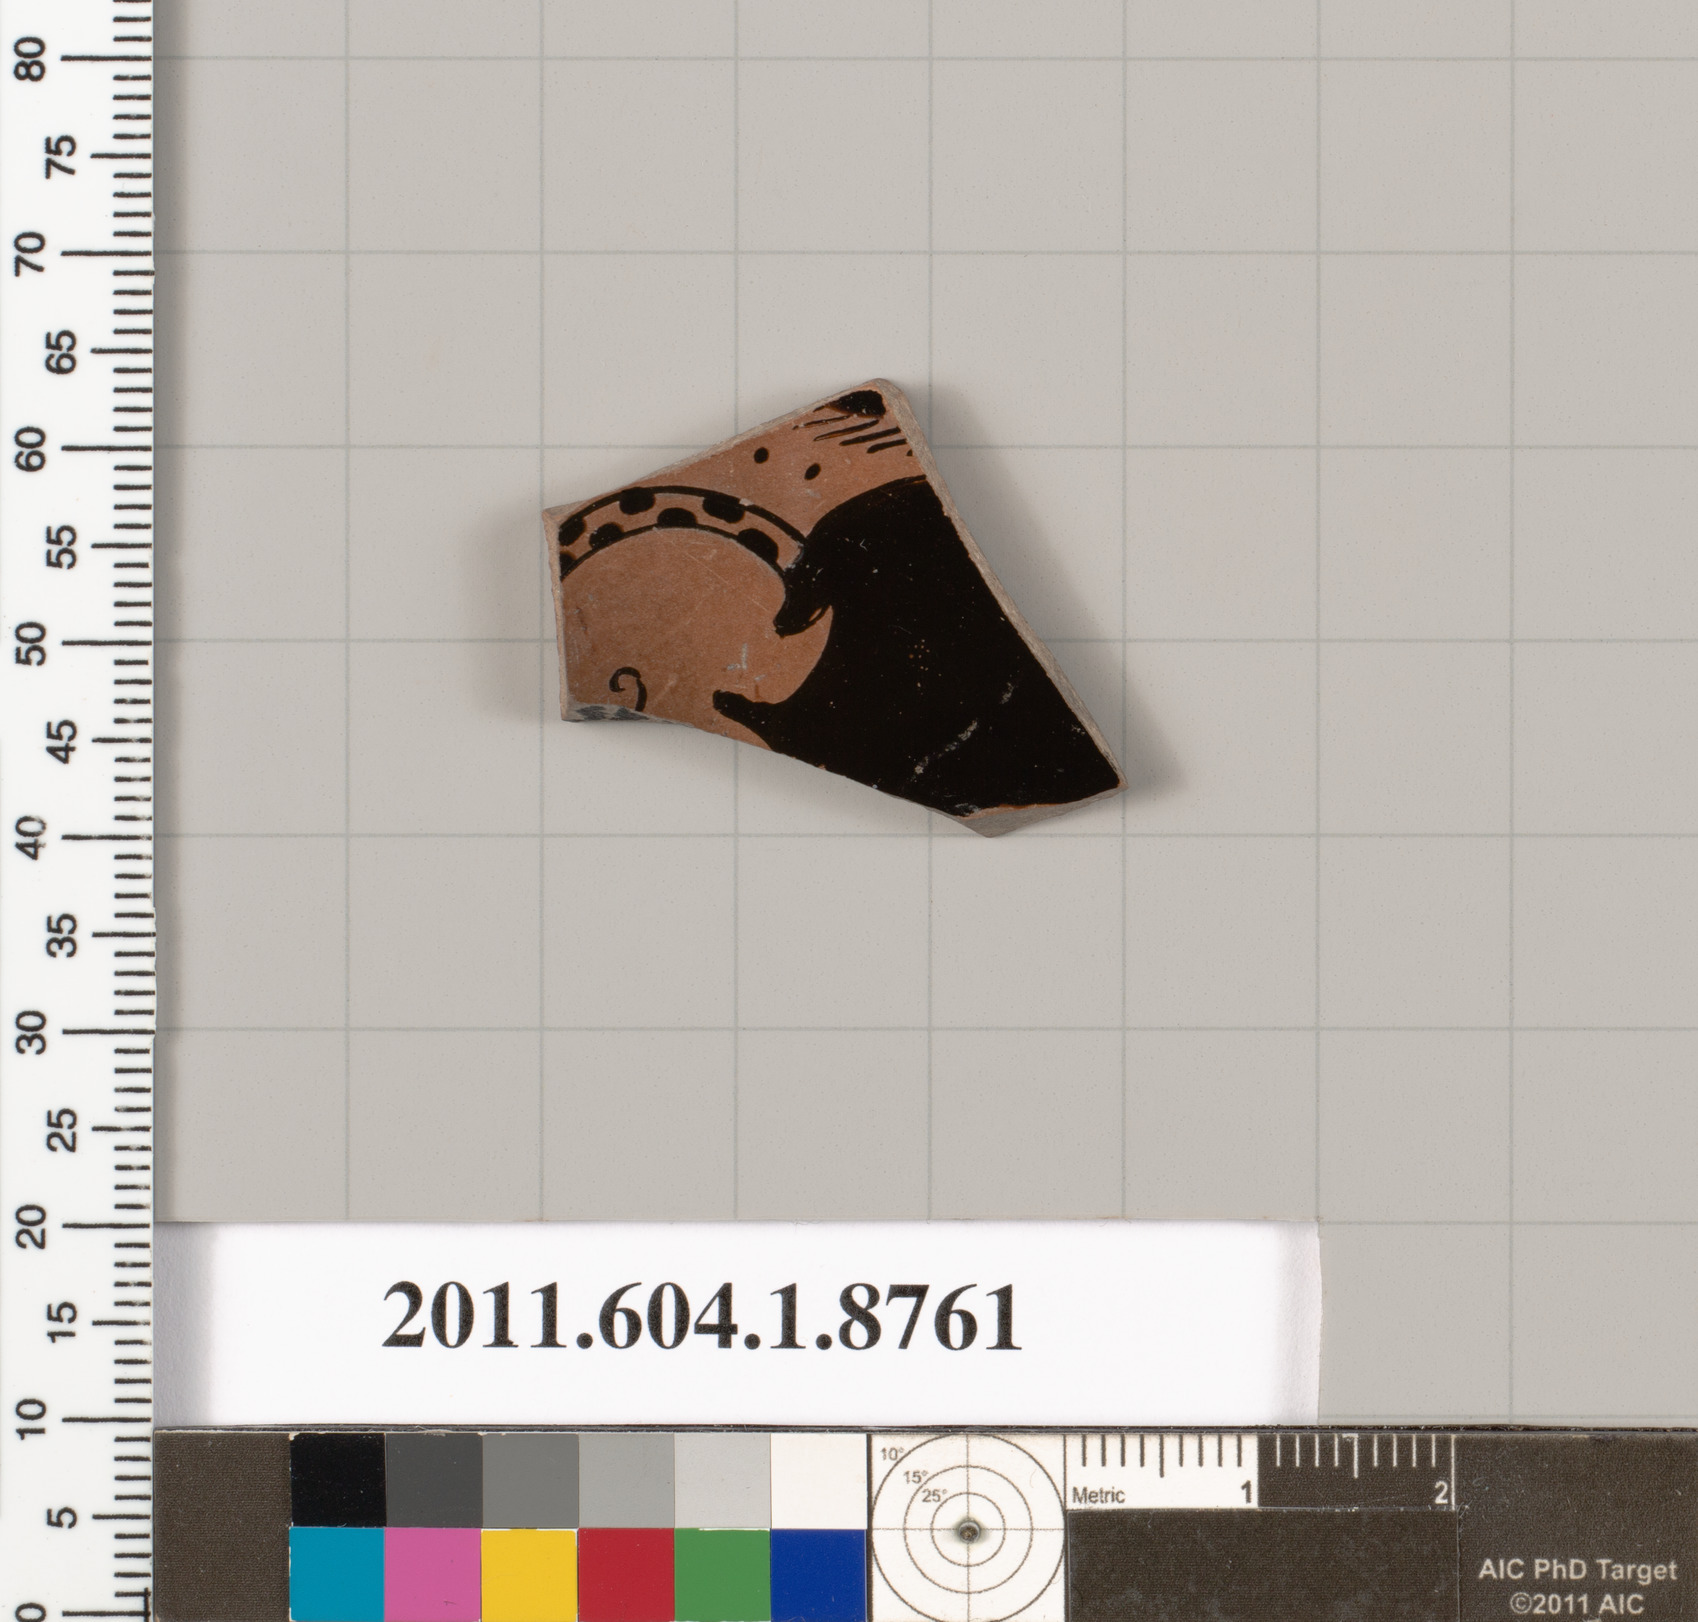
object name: kylix fragment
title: Terracotta fragment of a kylix (drinking cup)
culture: greek, attic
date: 490-480 BCE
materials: terracotta